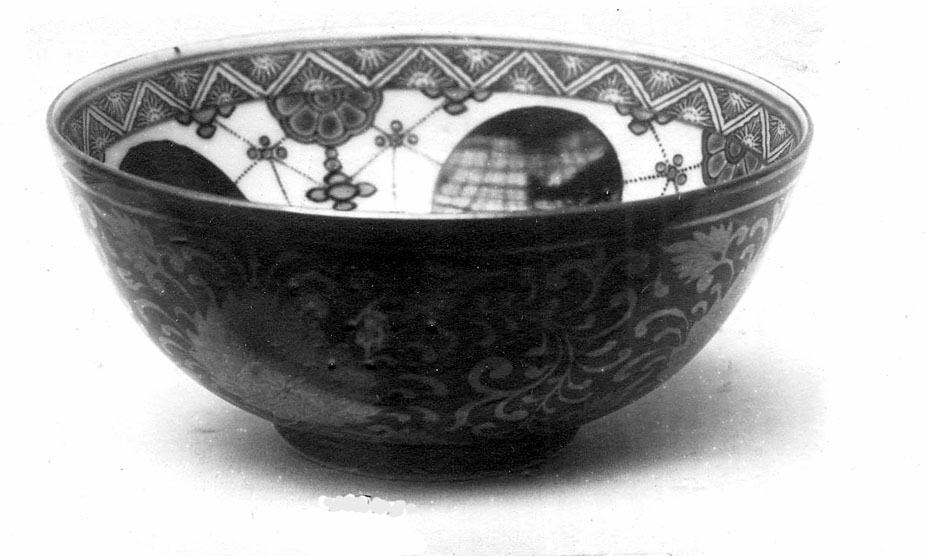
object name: bowl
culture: japanese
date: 1780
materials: enamel, glaze, gold, porcelain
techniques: painting